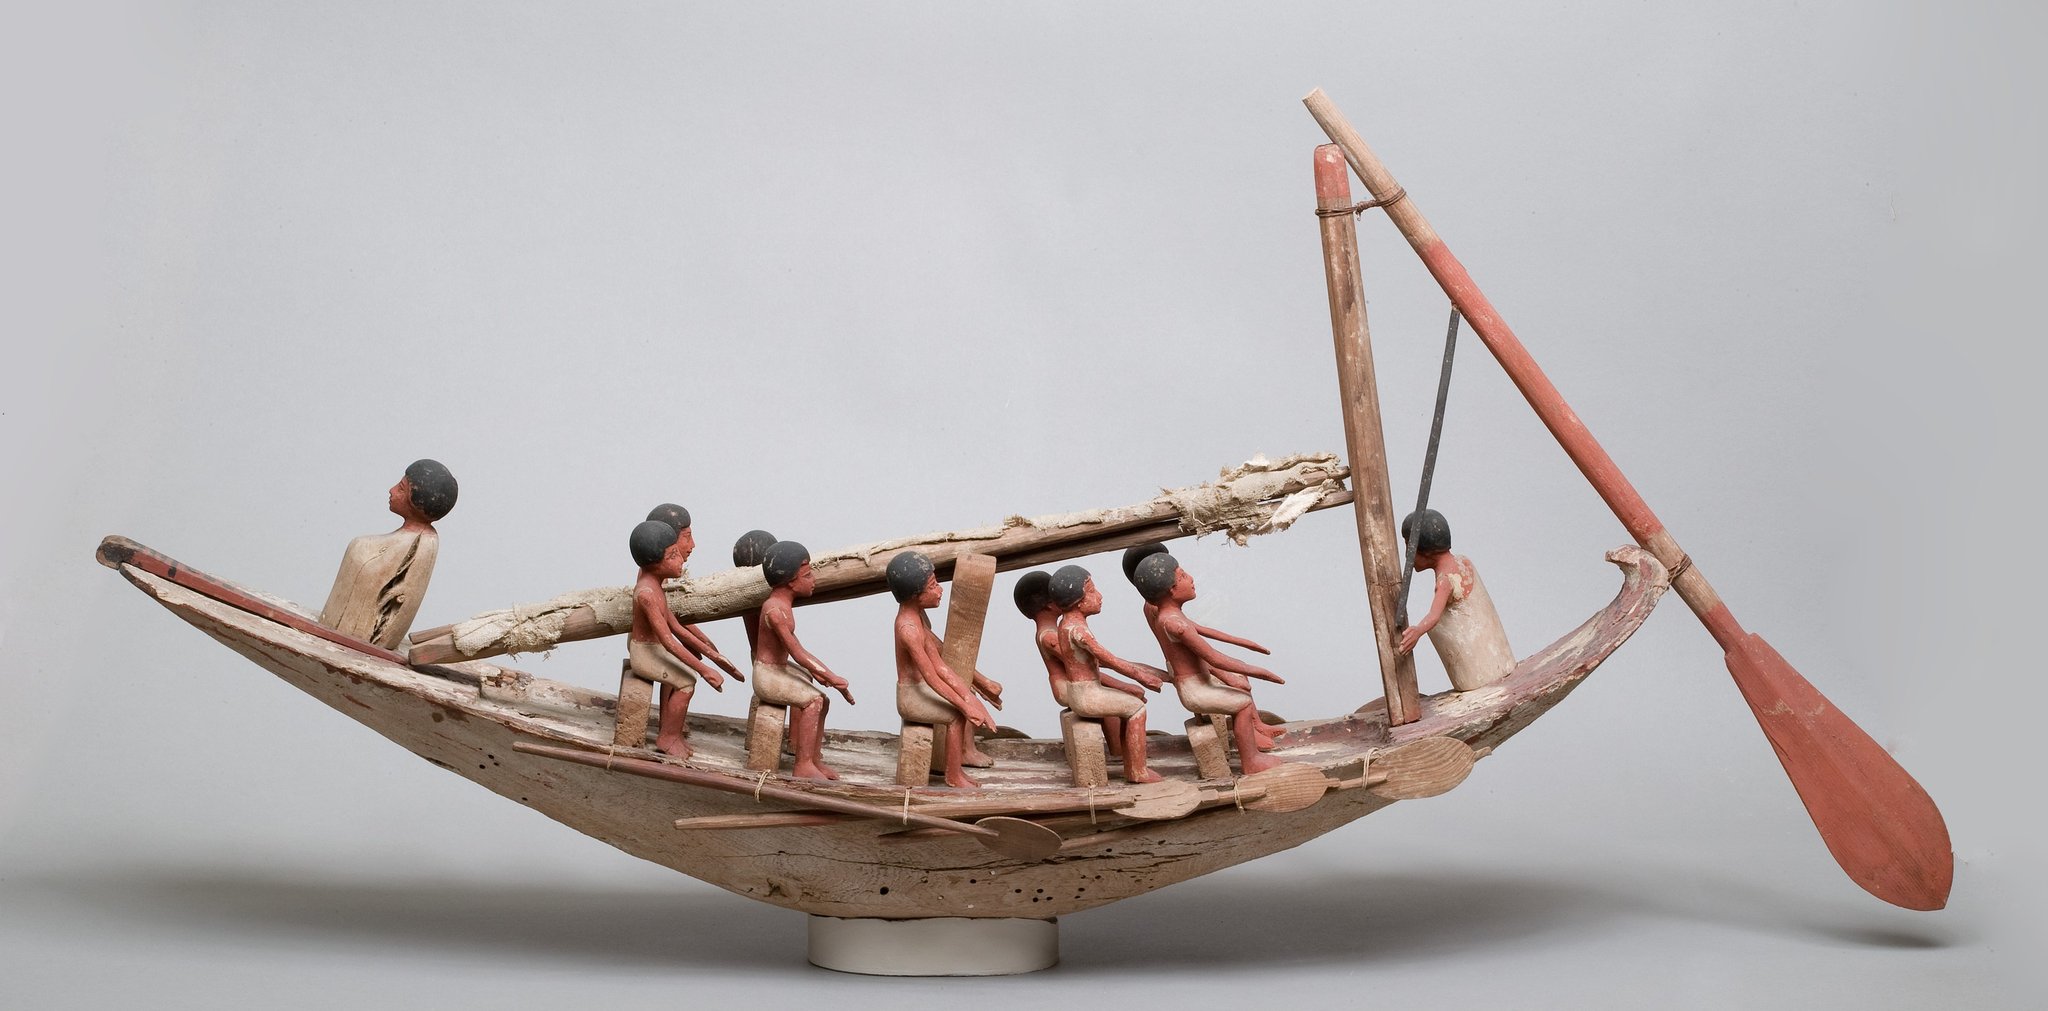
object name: model boat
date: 1981-1640 BCE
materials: paint, wood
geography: egypt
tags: men,boats